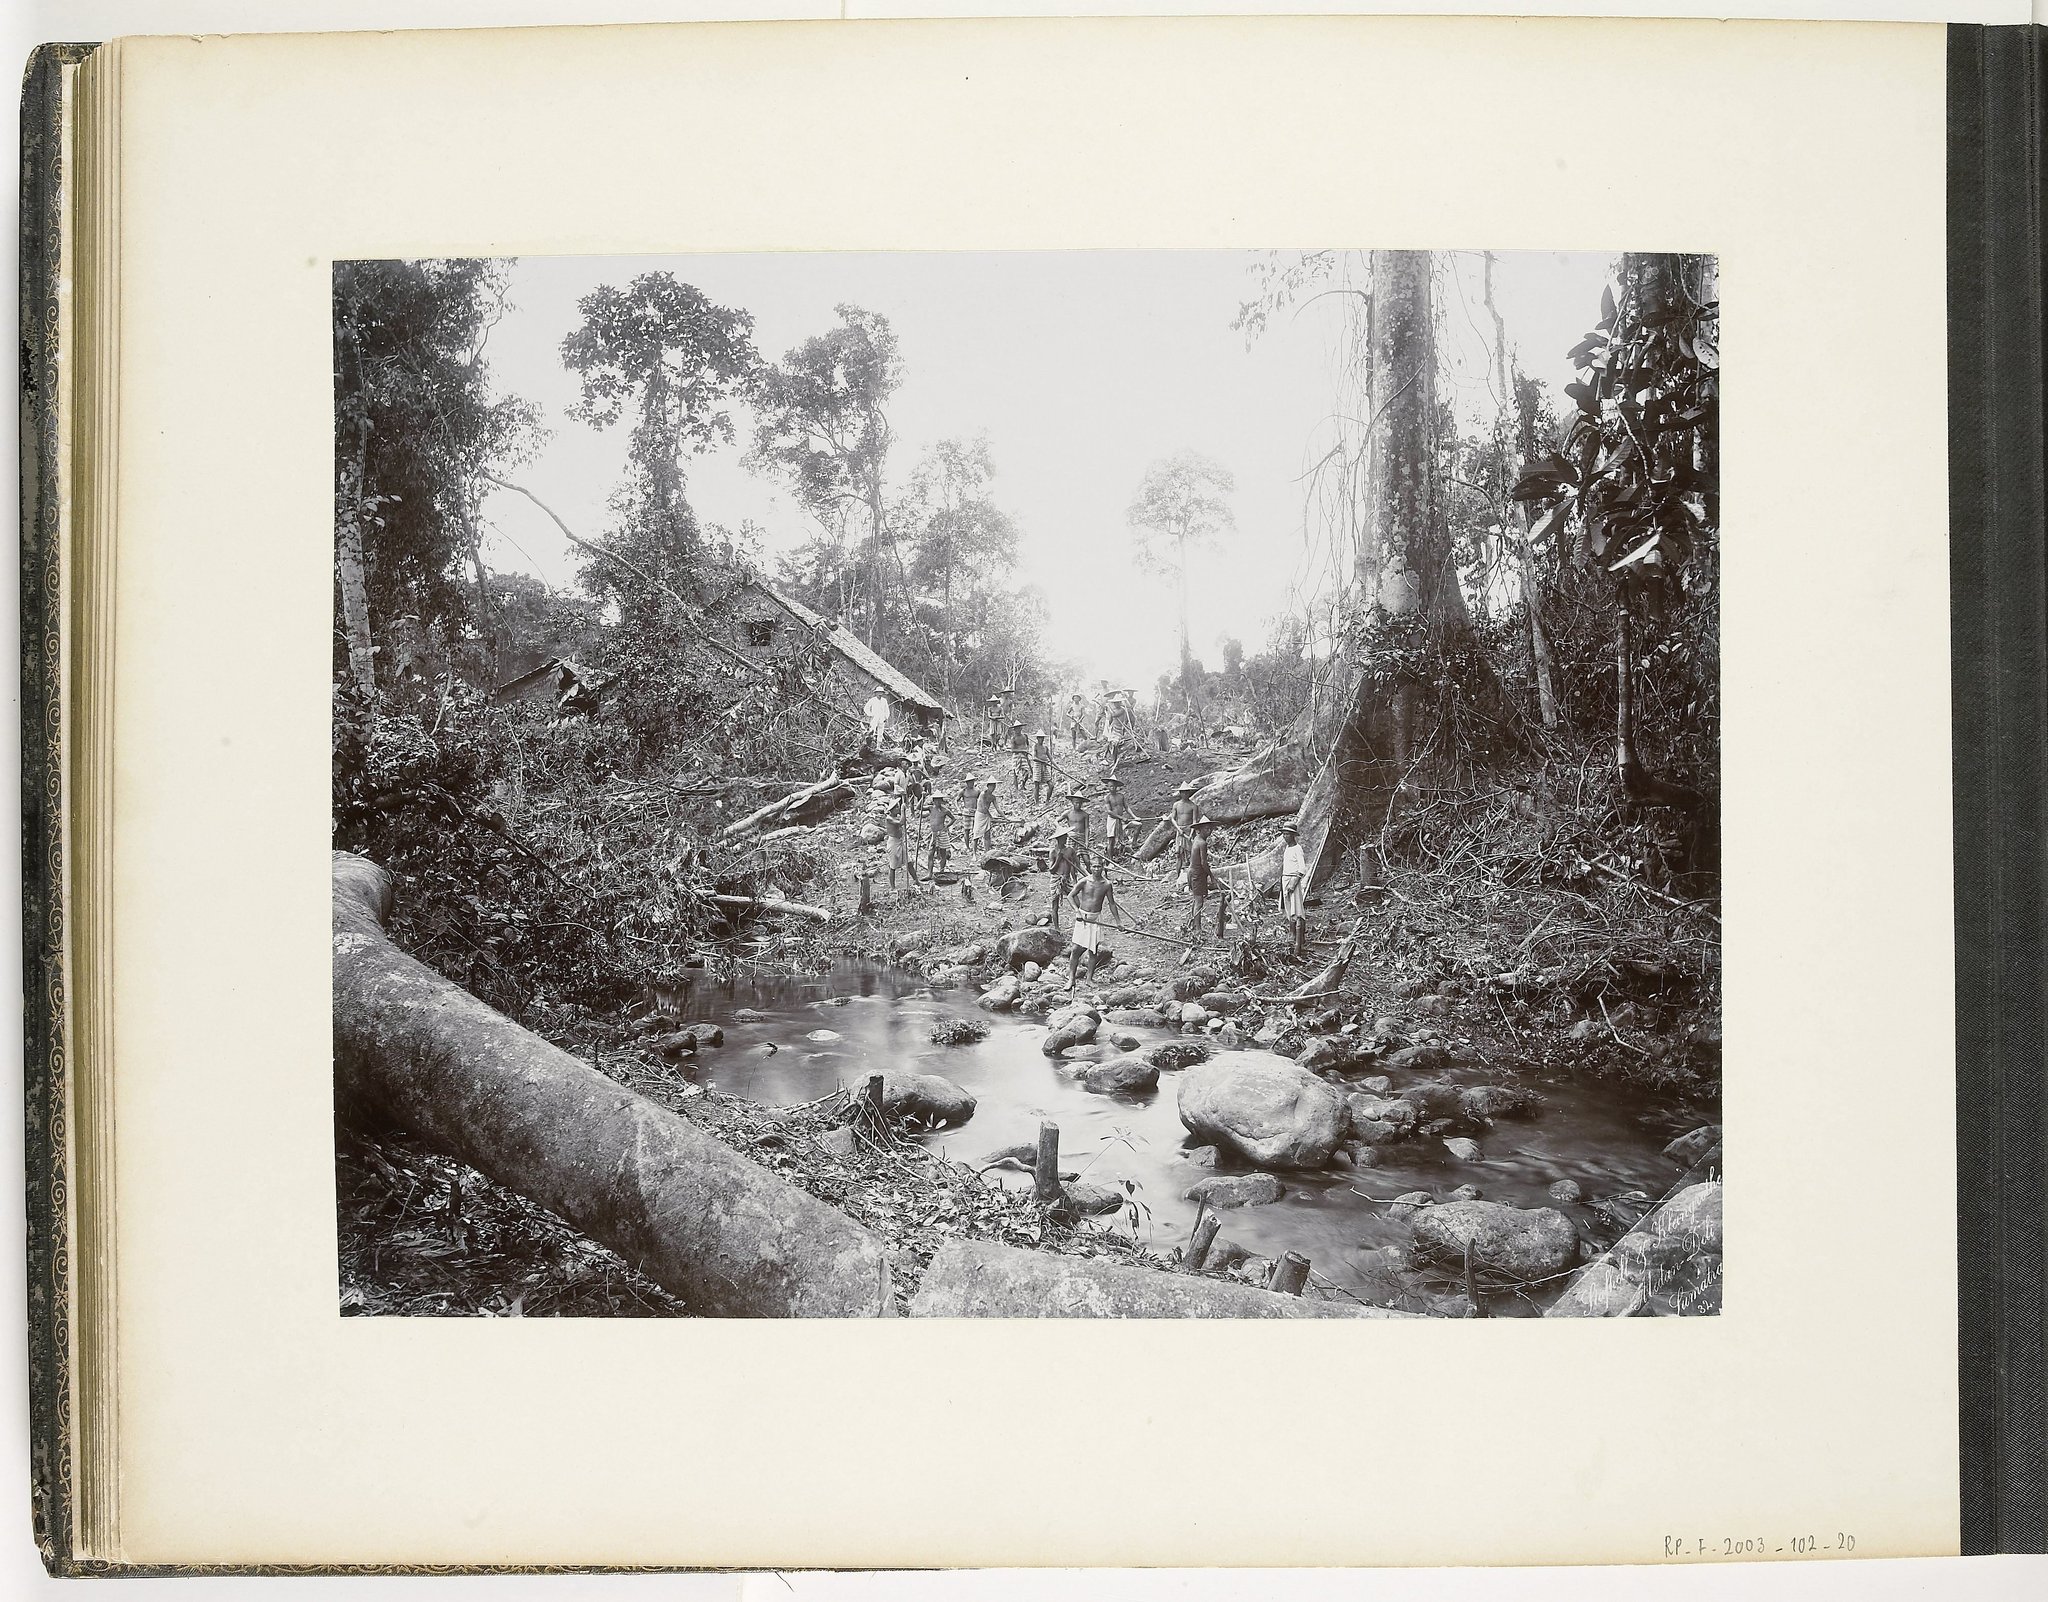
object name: photograph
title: Coolies constructing a road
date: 1890-1900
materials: photographic support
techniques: collodion silver print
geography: medan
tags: sumatra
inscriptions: number: ‘Sumatra 32.’, signature: ‘Stafhell & Kleingrothe Medan-Deli’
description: Chinese arbeiders bij bosontginning voor de aanleg van een weg op de Oostkust van Sumatra. Onderdeel van het Sumatra fotoalbum van Paul en Lucie Sandel uit 1900.